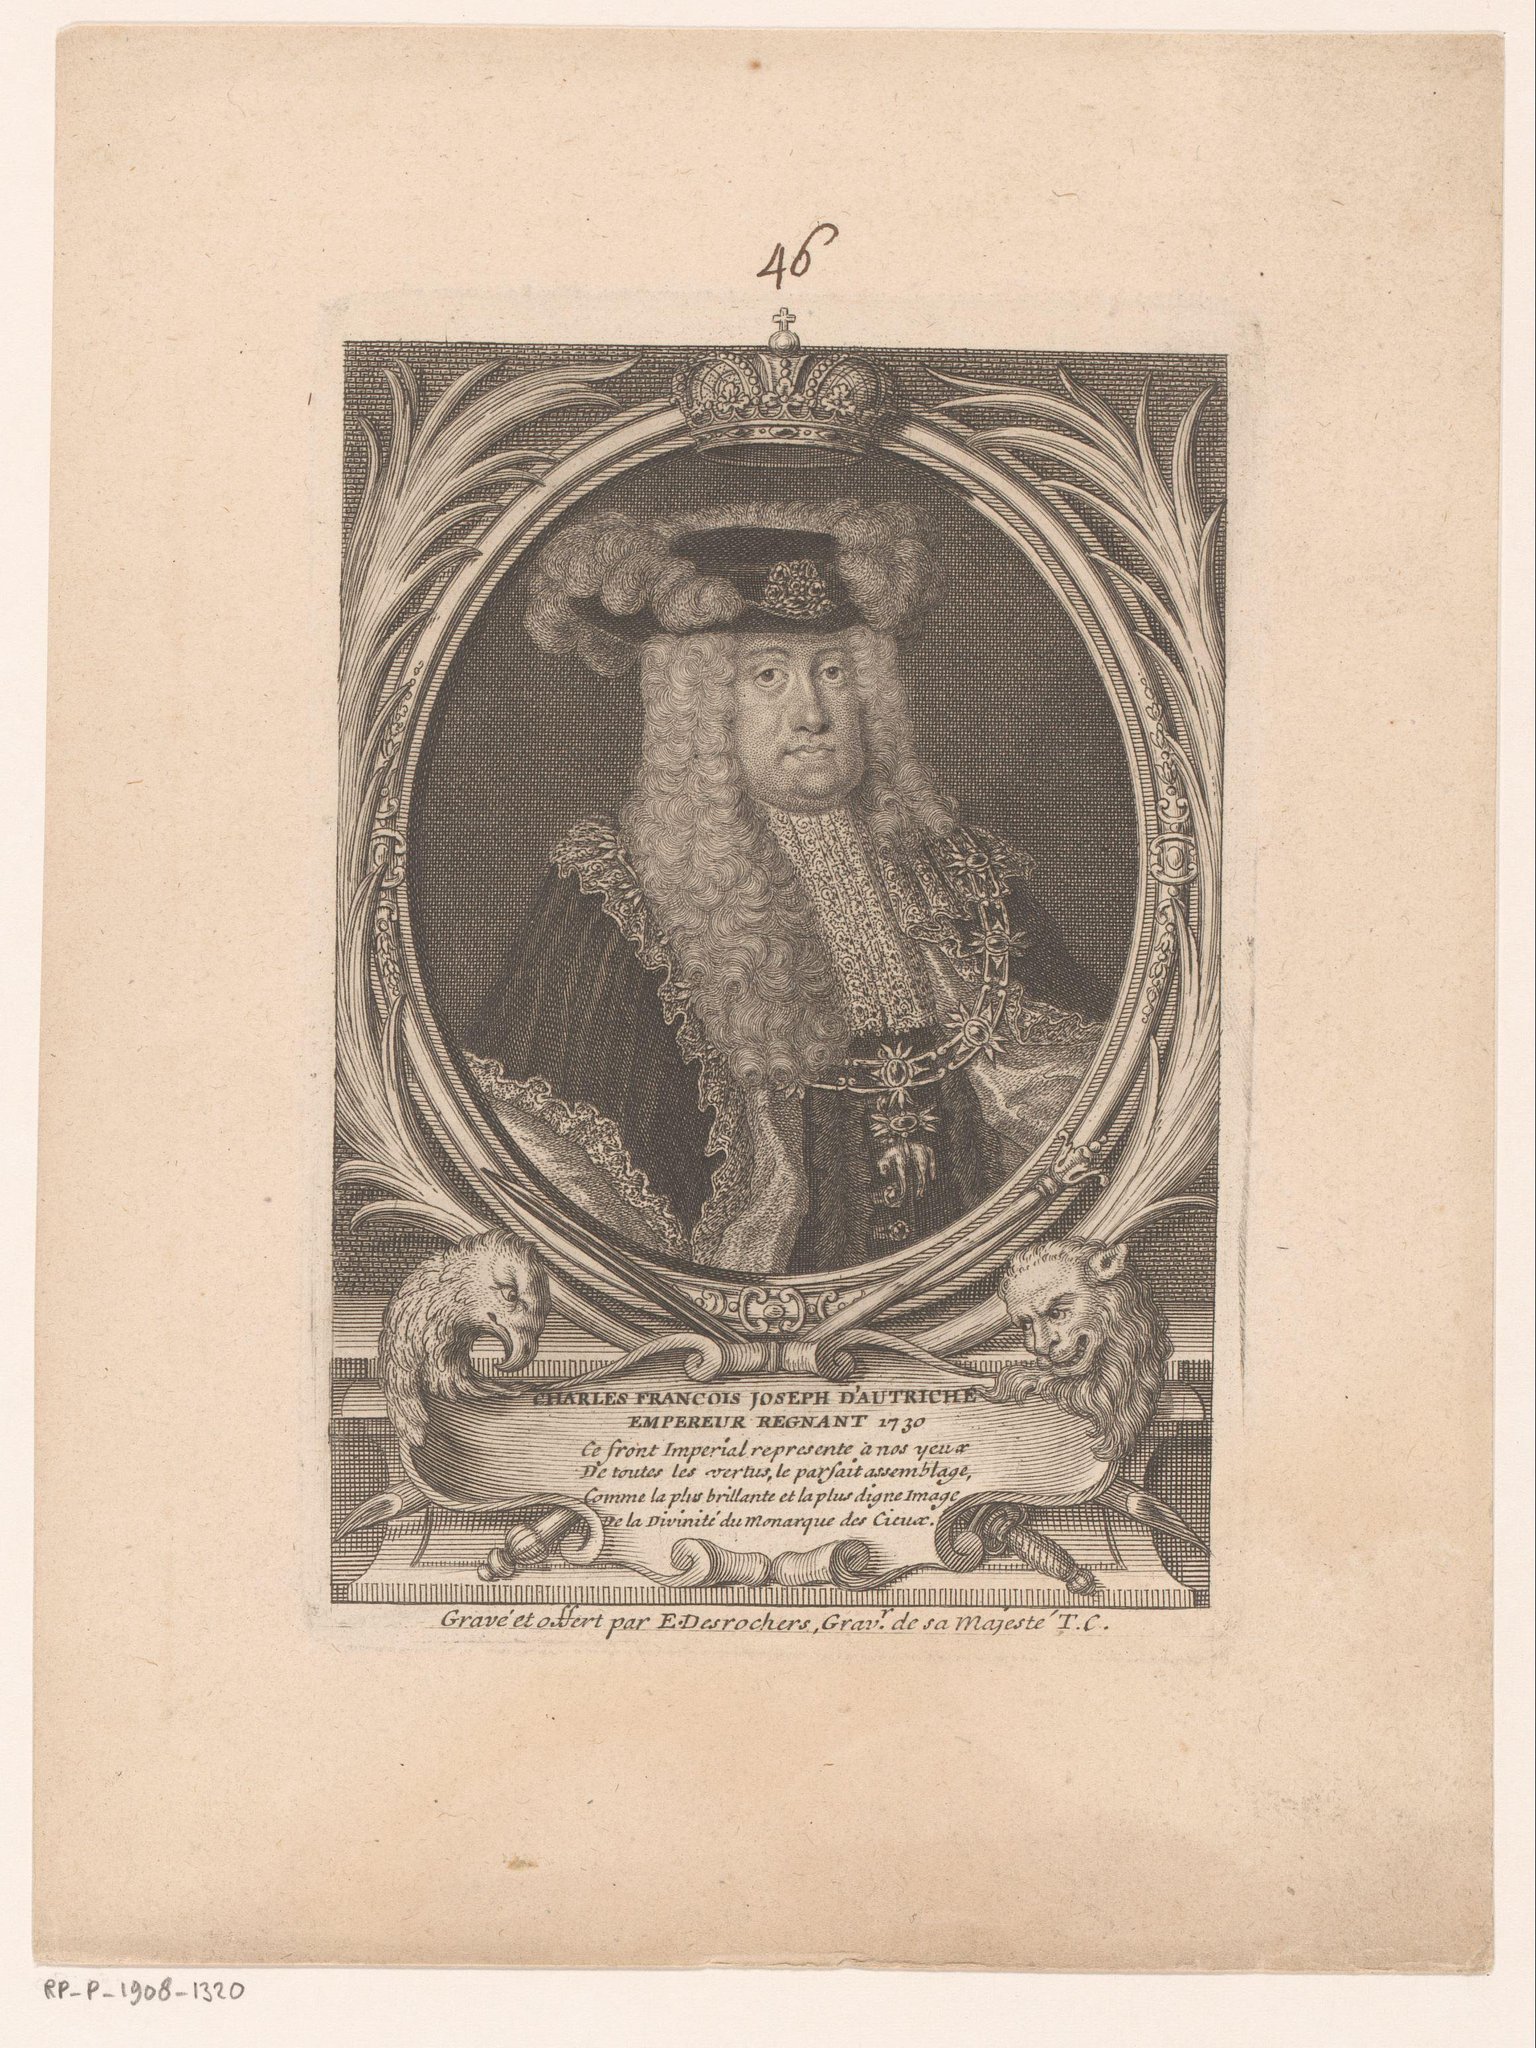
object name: print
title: Portret van keizer Karel VI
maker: étienne desrochers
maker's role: print maker, publisher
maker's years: 1668-1741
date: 1678-1741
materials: paper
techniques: engraving, etching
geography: paris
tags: charles vi (holy roman emperor), historical persons, emperor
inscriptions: collector's mark: Lugt 2228, number: ‘46’